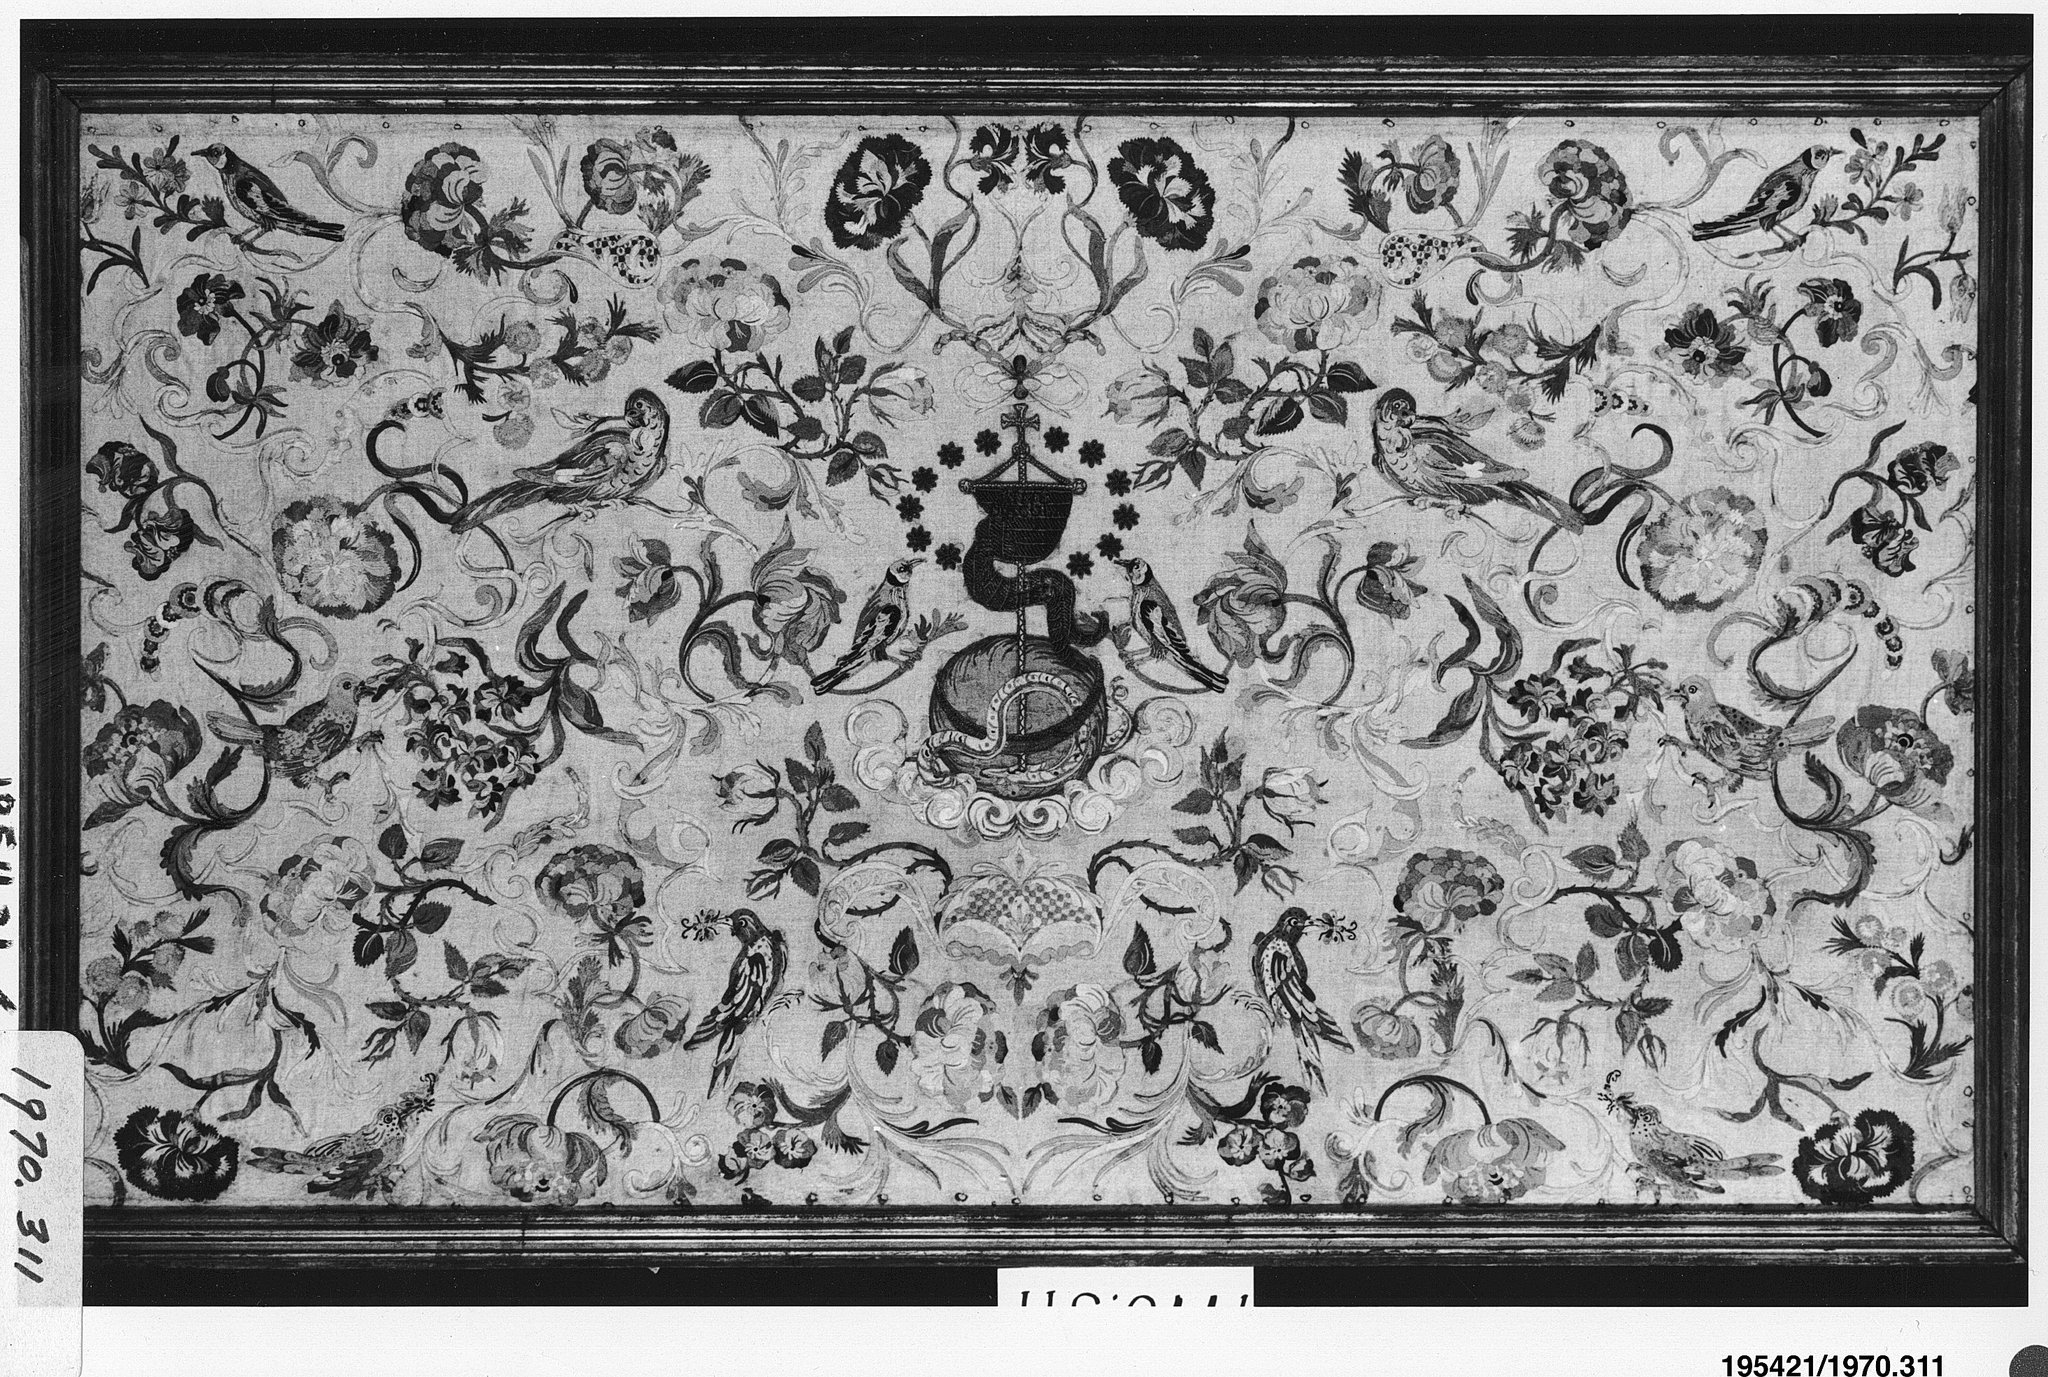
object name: altar frontal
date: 1701-1800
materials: silk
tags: birds,flowers